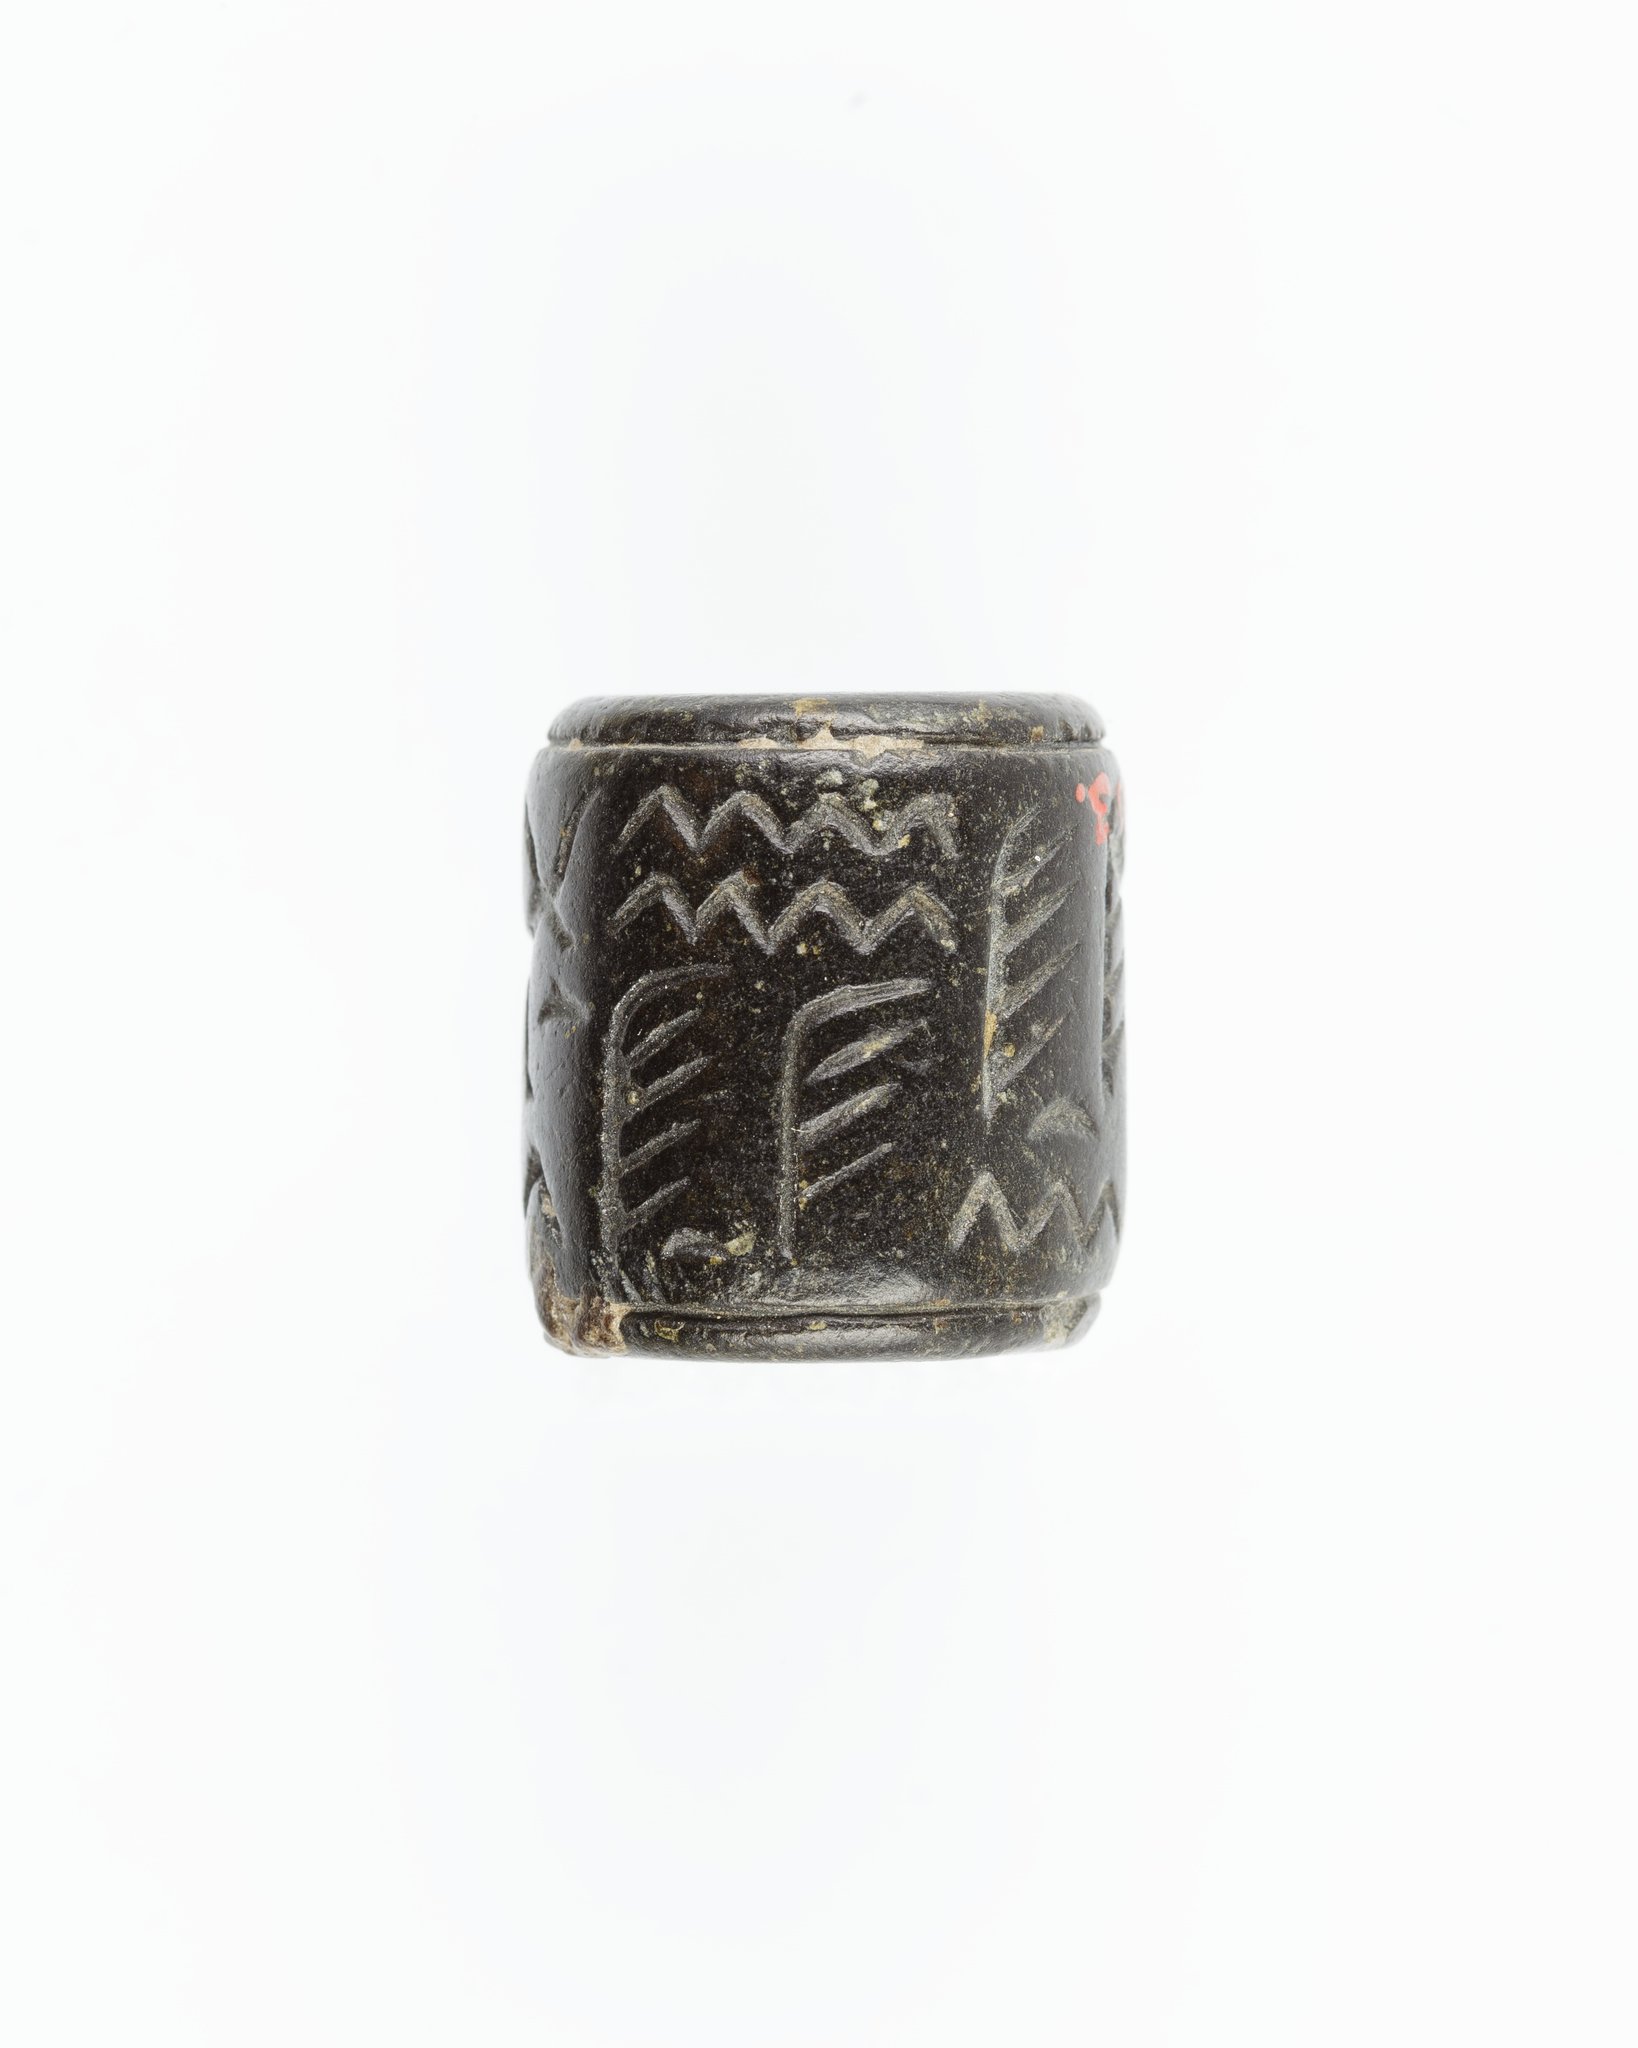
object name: cylinder seal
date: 2960-2649 BCE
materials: stone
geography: egypt